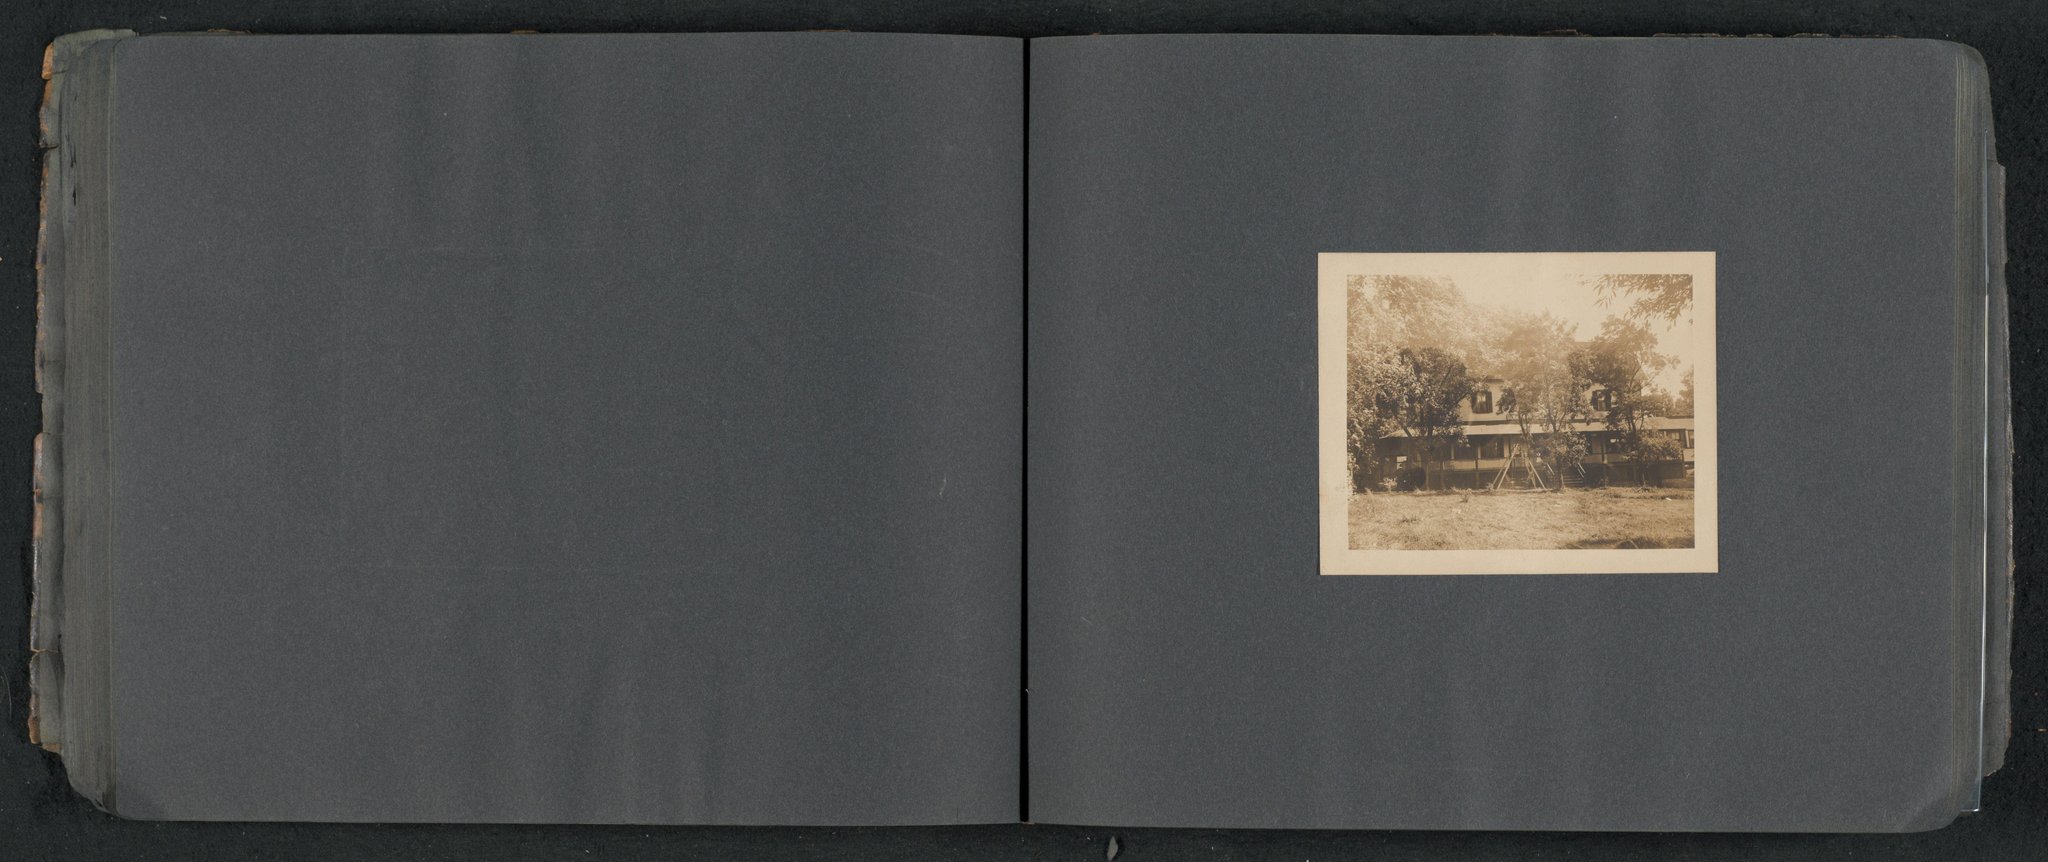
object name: photograph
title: Beecher House, vermoedelijk in Litchfield (Connecticut)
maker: Anonymous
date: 1890-1902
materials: paper, photographic support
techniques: gelatin silver print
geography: united states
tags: historical persons, rural housing, e.g. country-house, villa, cottage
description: Albumblad met een houten huis tussen de bomen met een veranda en een naamplaat aan de gevel. Onderdeel van Familiealbum met voornamelijk foto's van een jong Amerikaans meisje.